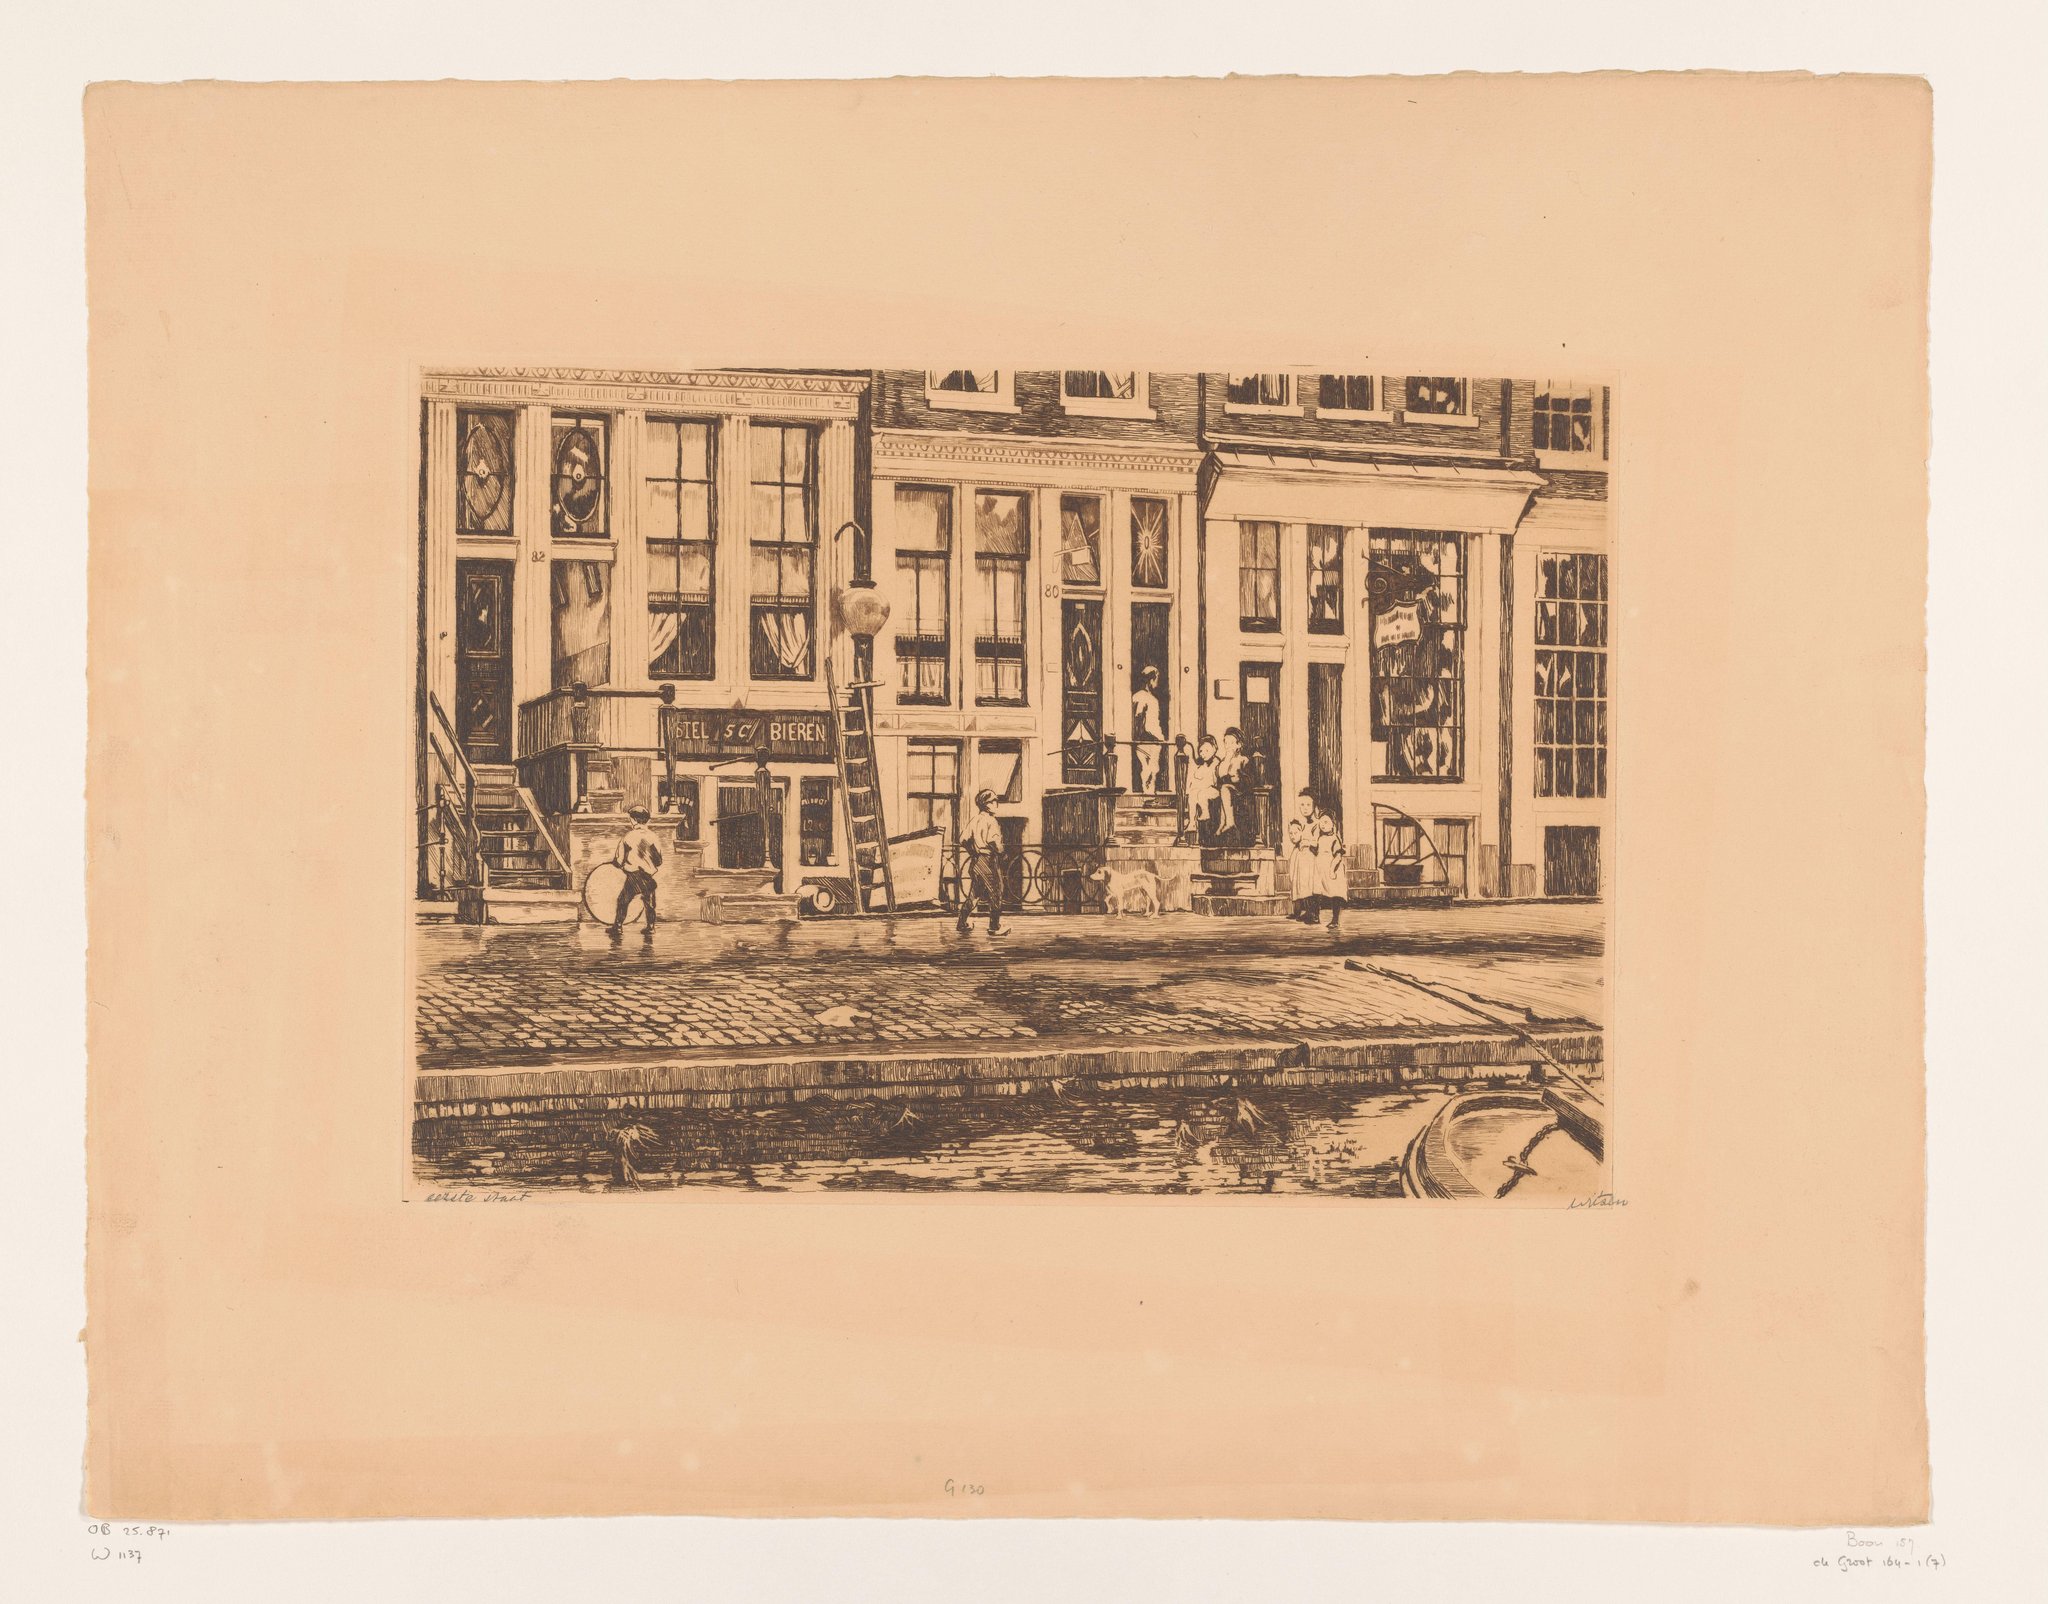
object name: print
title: Oude Waal met de wasinrichting van de gezusters Veltkamp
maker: willem witsen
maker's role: draughtsman, painter, print maker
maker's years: 1860-1923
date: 1912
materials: paper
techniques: etching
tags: urban housing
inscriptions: annotation: ‘eerste staat’